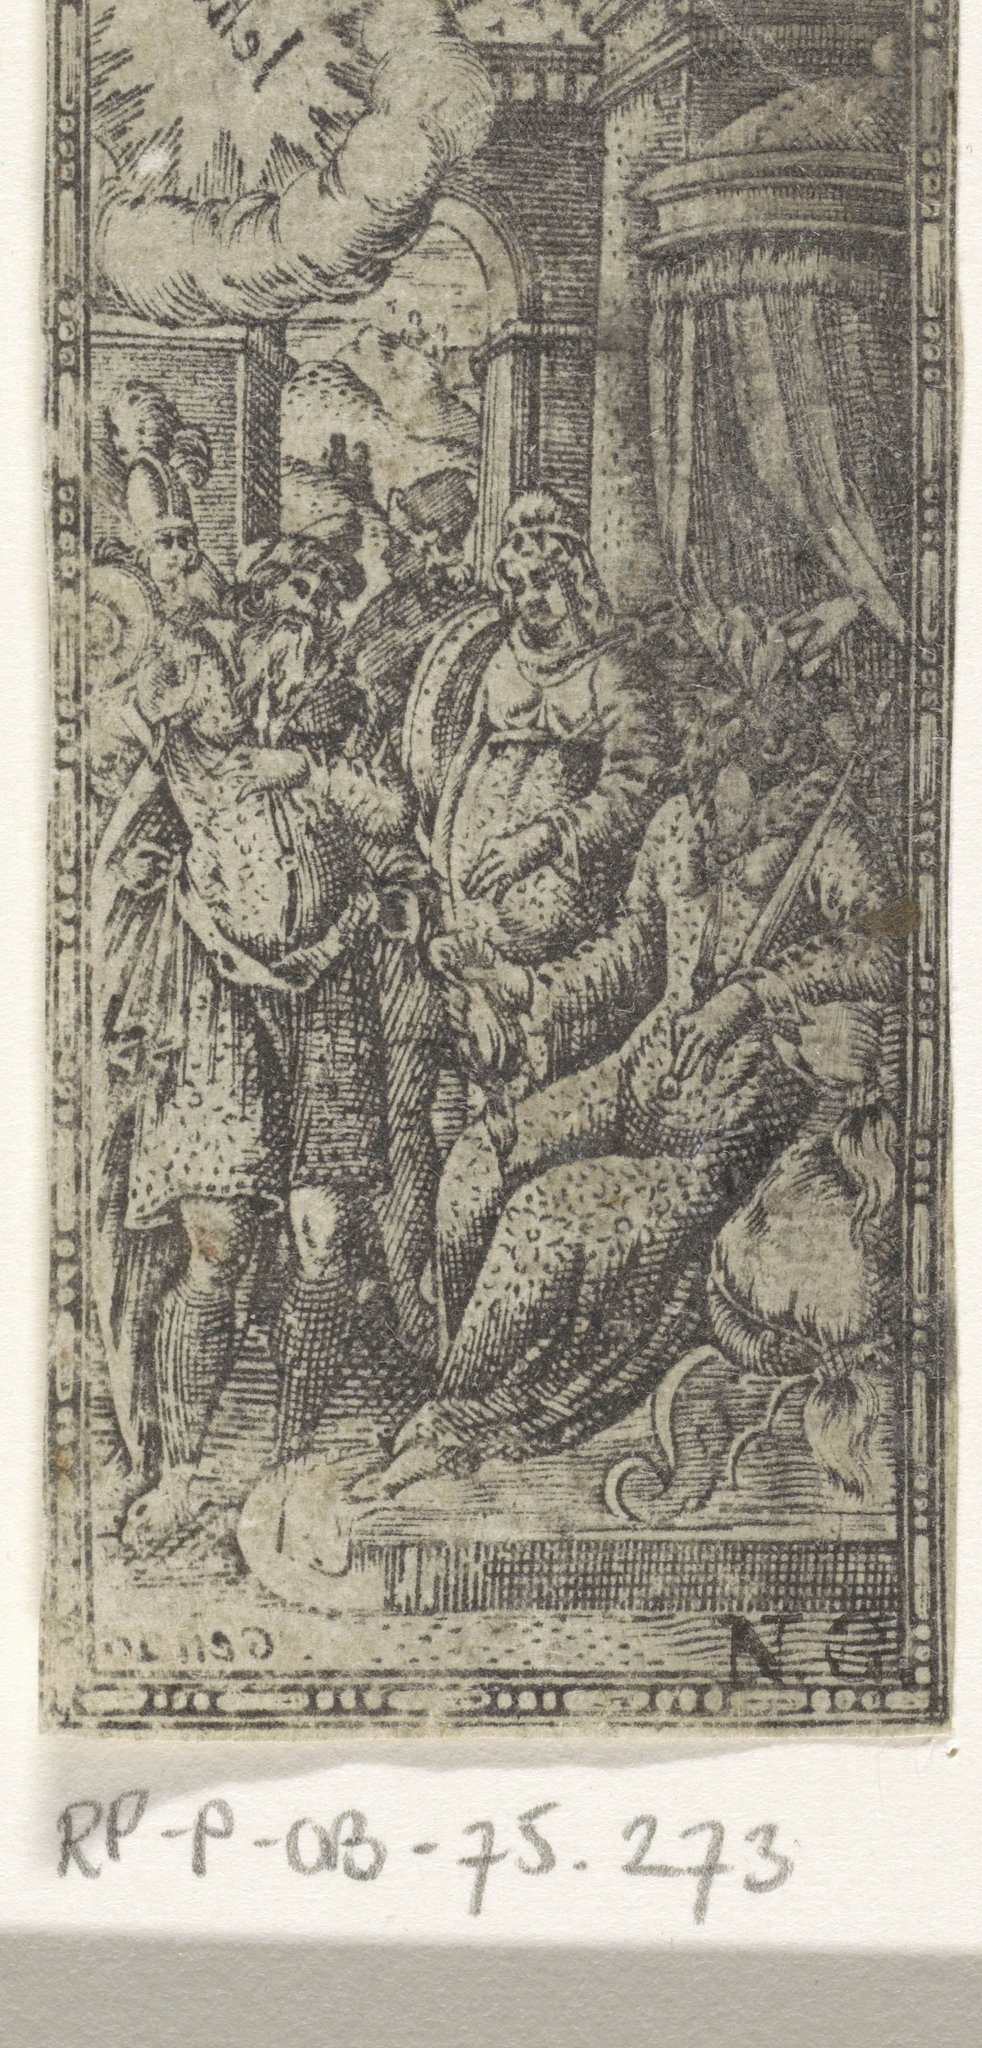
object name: print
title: Verhalen uit het Bijbelboek Genesis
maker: Anonymous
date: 1500-1600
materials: paper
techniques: engraving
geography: netherlands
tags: abraham is summoned before abimelech; sarah is given back to abraham, who is honoured with a thousand pieces of silver and other gifts, (rays of) light ~ symbol of god the father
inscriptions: collector's mark: Lugt 2228, collector's mark: Lugt 1967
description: Abraham en Sara staan bij Abimelech, koning van Gerar, die op zijn troon zit. Abimelech had Sara naar zijn paleis laten brengen, omdat Abraham had gezegd dat ze zijn zus was, maar daar ontdekte hij dat ze getrouwd was met Abraham. In de linkerbovenhoek een lichtkrans met de tekst Jehova (spiegelbeeldig) als symbool van God de Vader. In de linkeronderhoek een verwijzing naar Gen. 20 in spiegelbeeld.